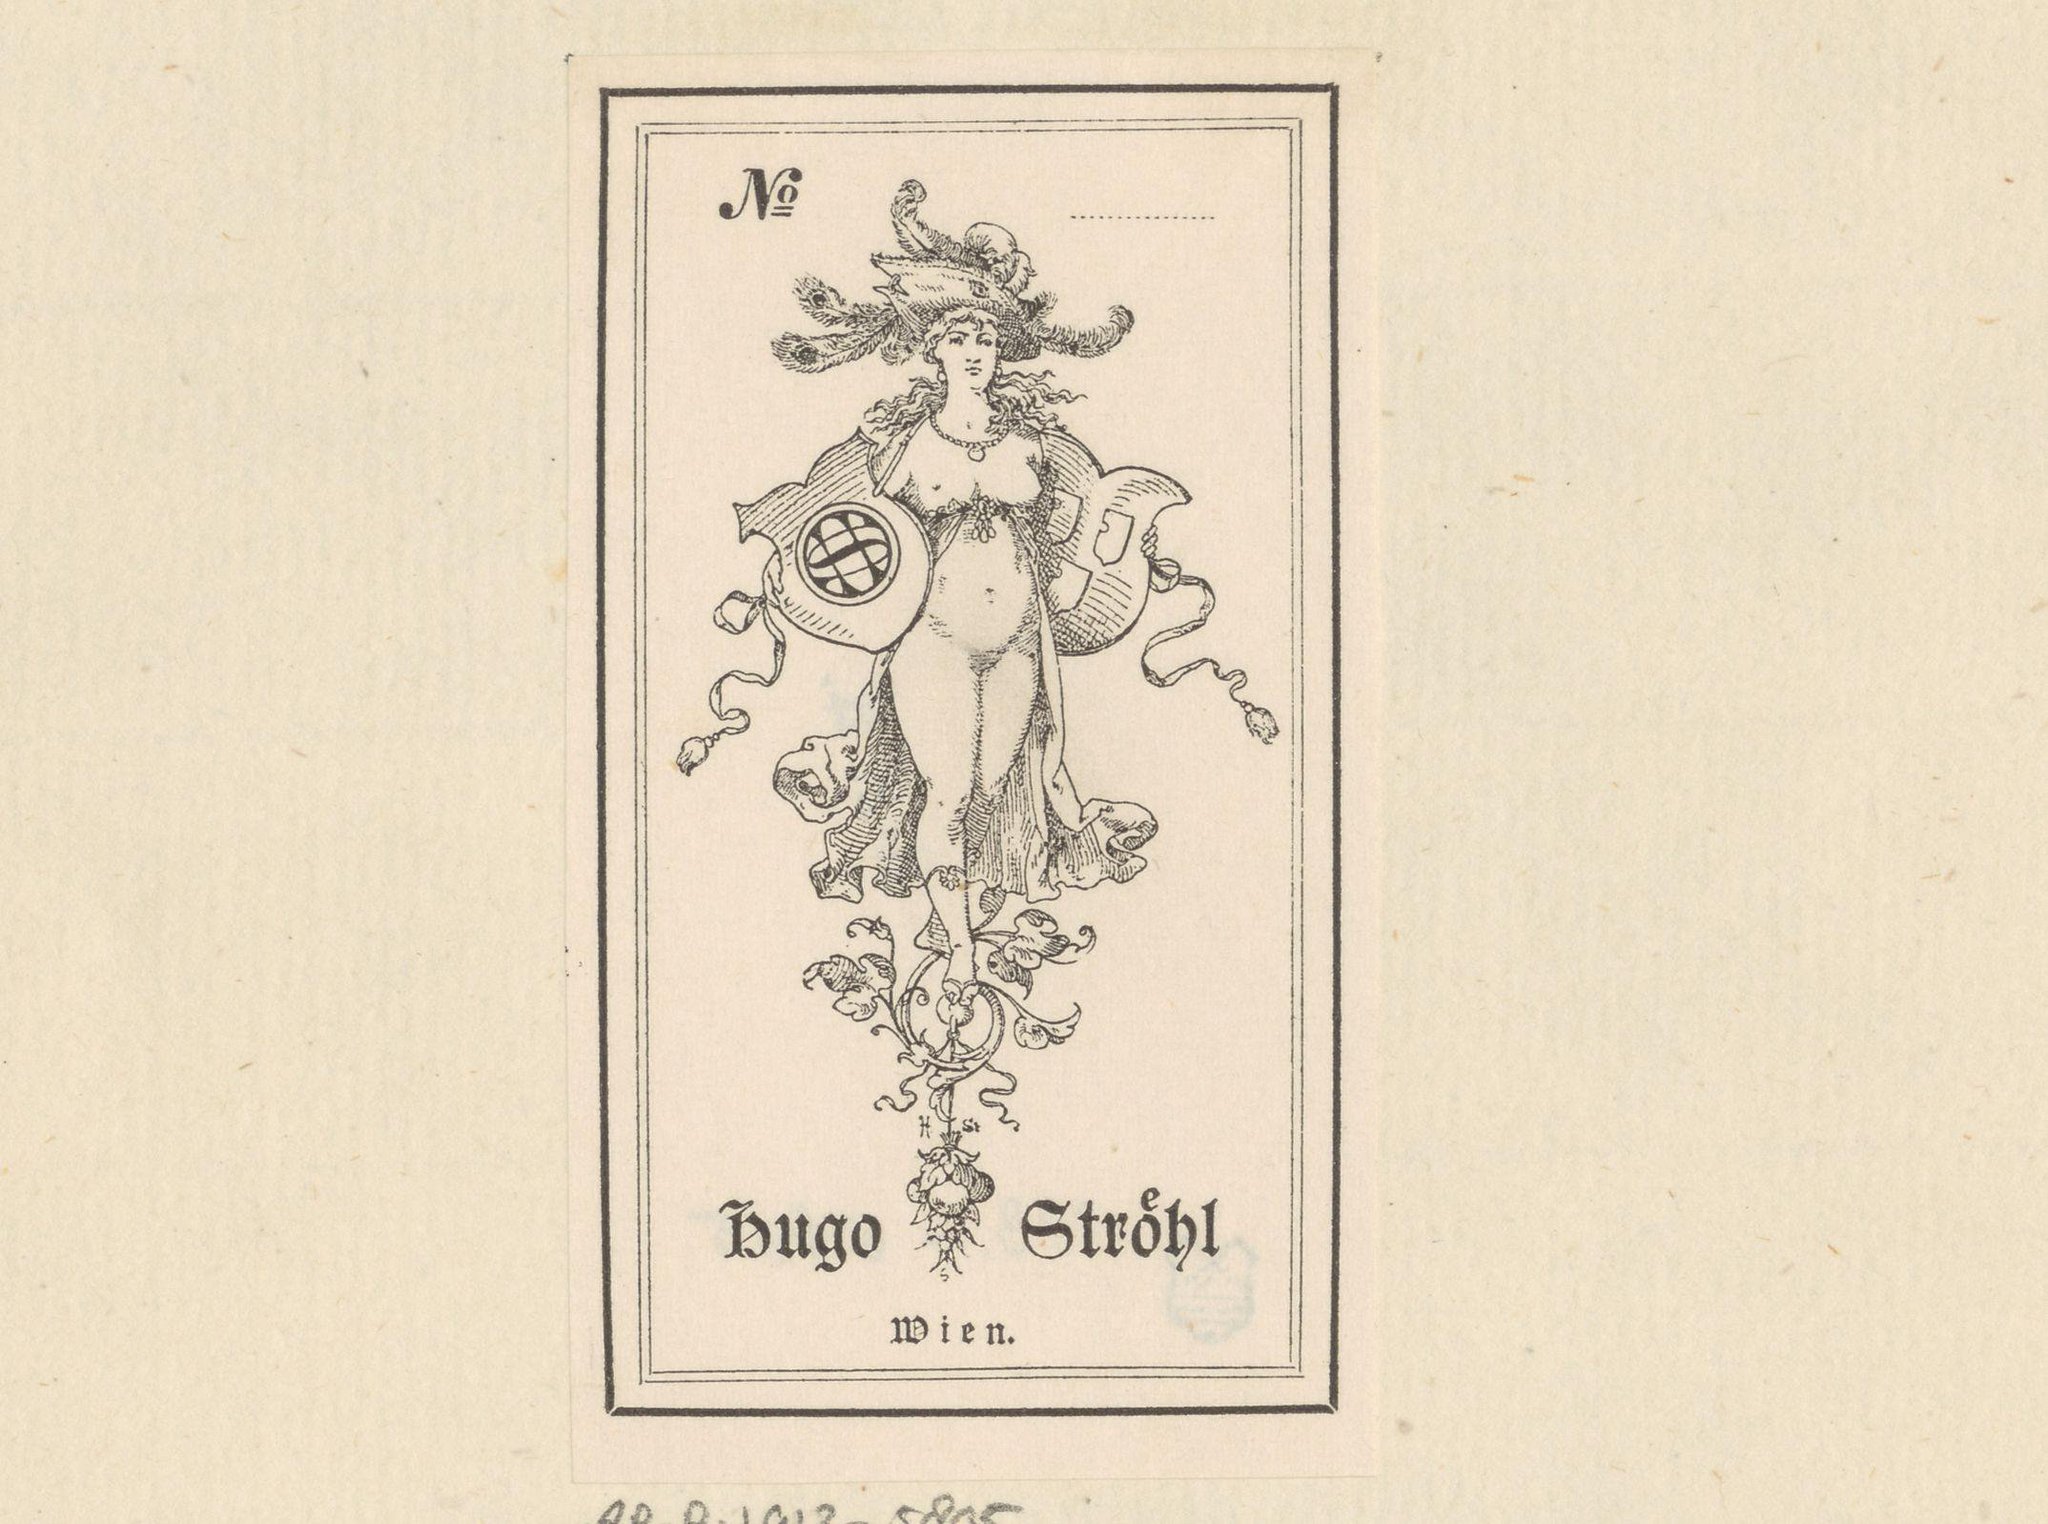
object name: bookplate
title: Ex libris van Hugo Ströhl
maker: Anonymous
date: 1861-1913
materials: paper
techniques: printing block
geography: austria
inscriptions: collector's mark: Lugt 2760, collector's mark: Lugt 2233